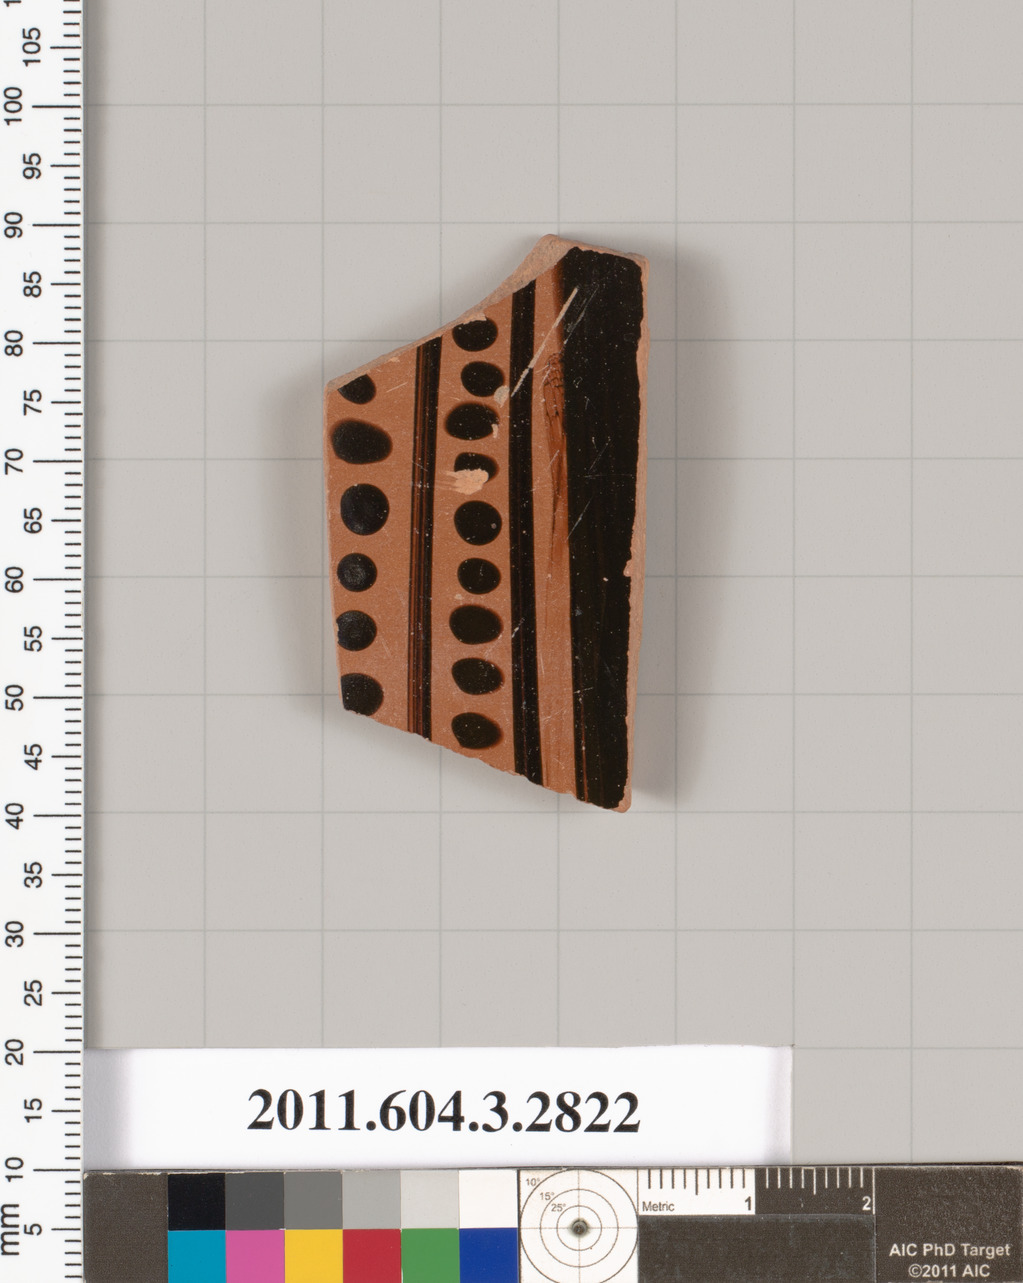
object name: pelike fragment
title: Terracotta fragment of a pelike (jar)?Pelike fragment?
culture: greek, attic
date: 534-468 BCE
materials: terracotta